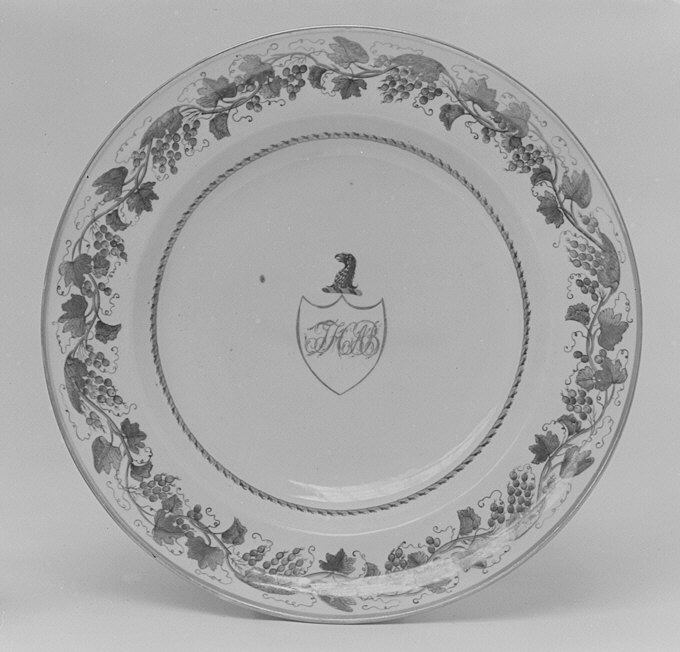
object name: soup dish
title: Soup dish (part of a service)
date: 1790-1800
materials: hard paste porcelain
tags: grapes,insignia